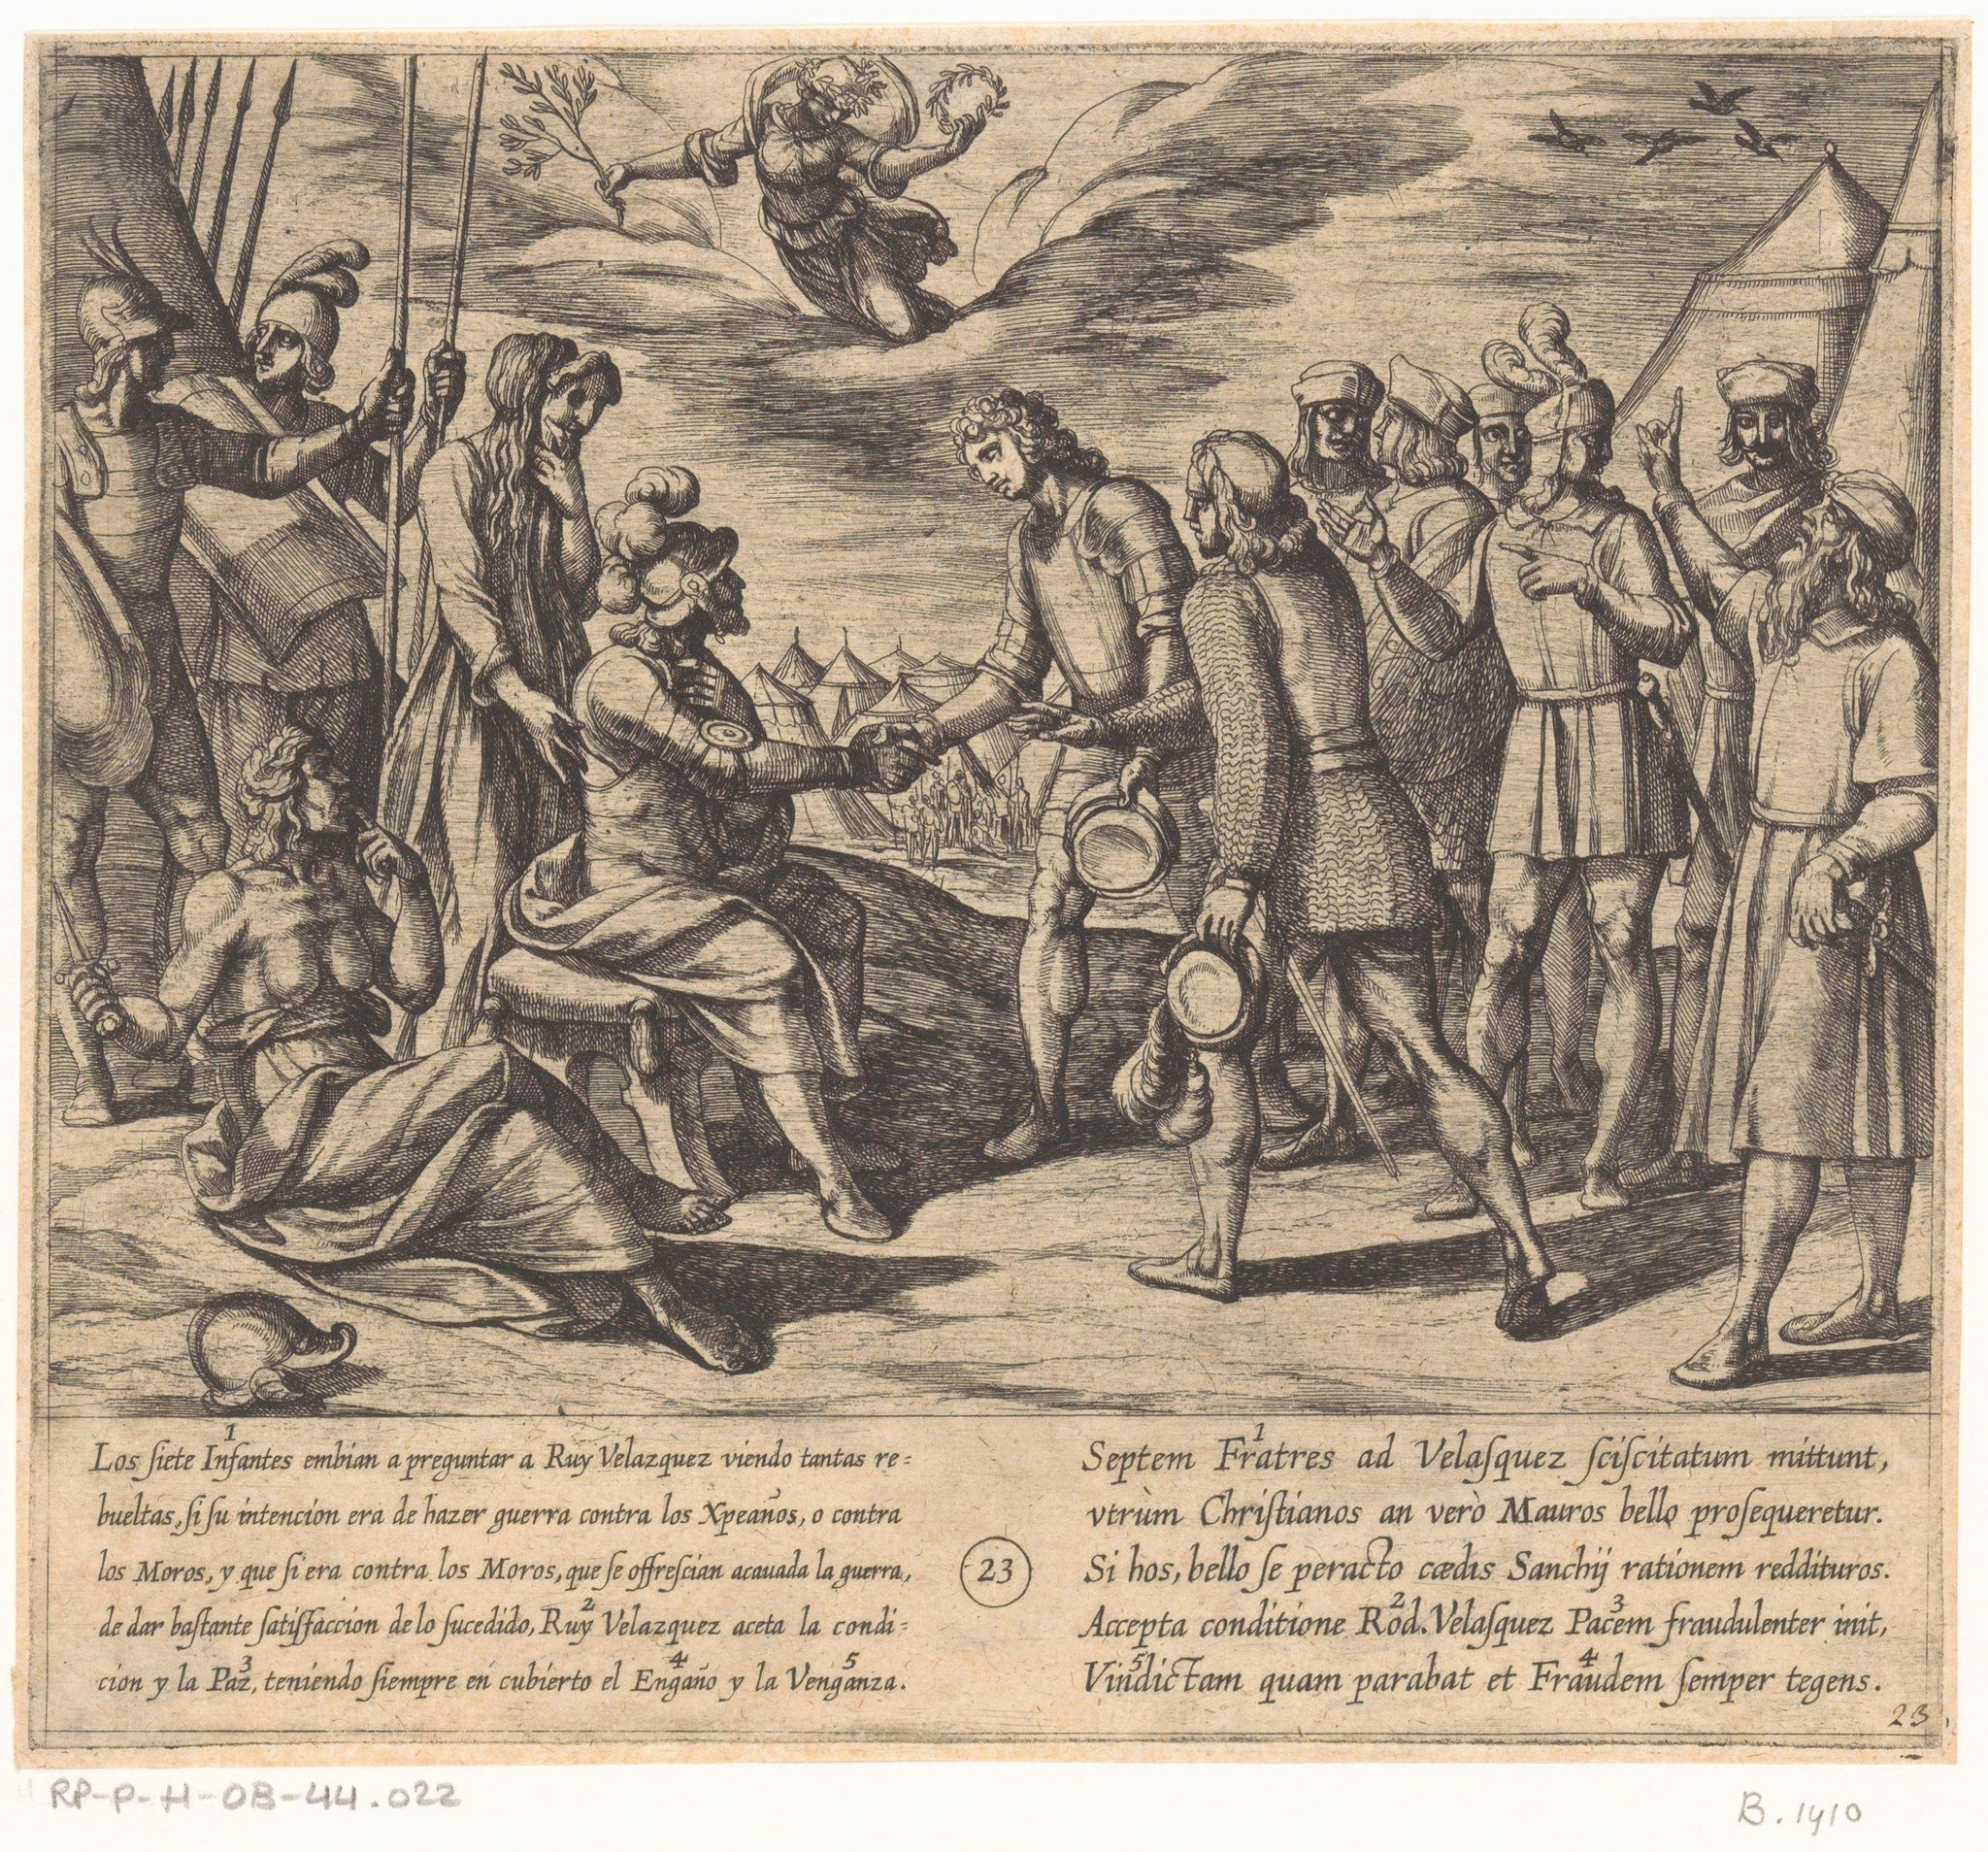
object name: print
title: De zeven infanten van Lara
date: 1612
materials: paper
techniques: etching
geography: antwerp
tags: (military) camp with tents, peace negotiations, tales and fairy tales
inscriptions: collector's mark: ‘Hinloopen’, number: ‘23’, collector's mark: Lugt 11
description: Deze prent maakt deel uit van een reeks van 40 prenten (+ titelprent) met voorstellingen uit het volksverhaal over de zeven infanten van Lara.